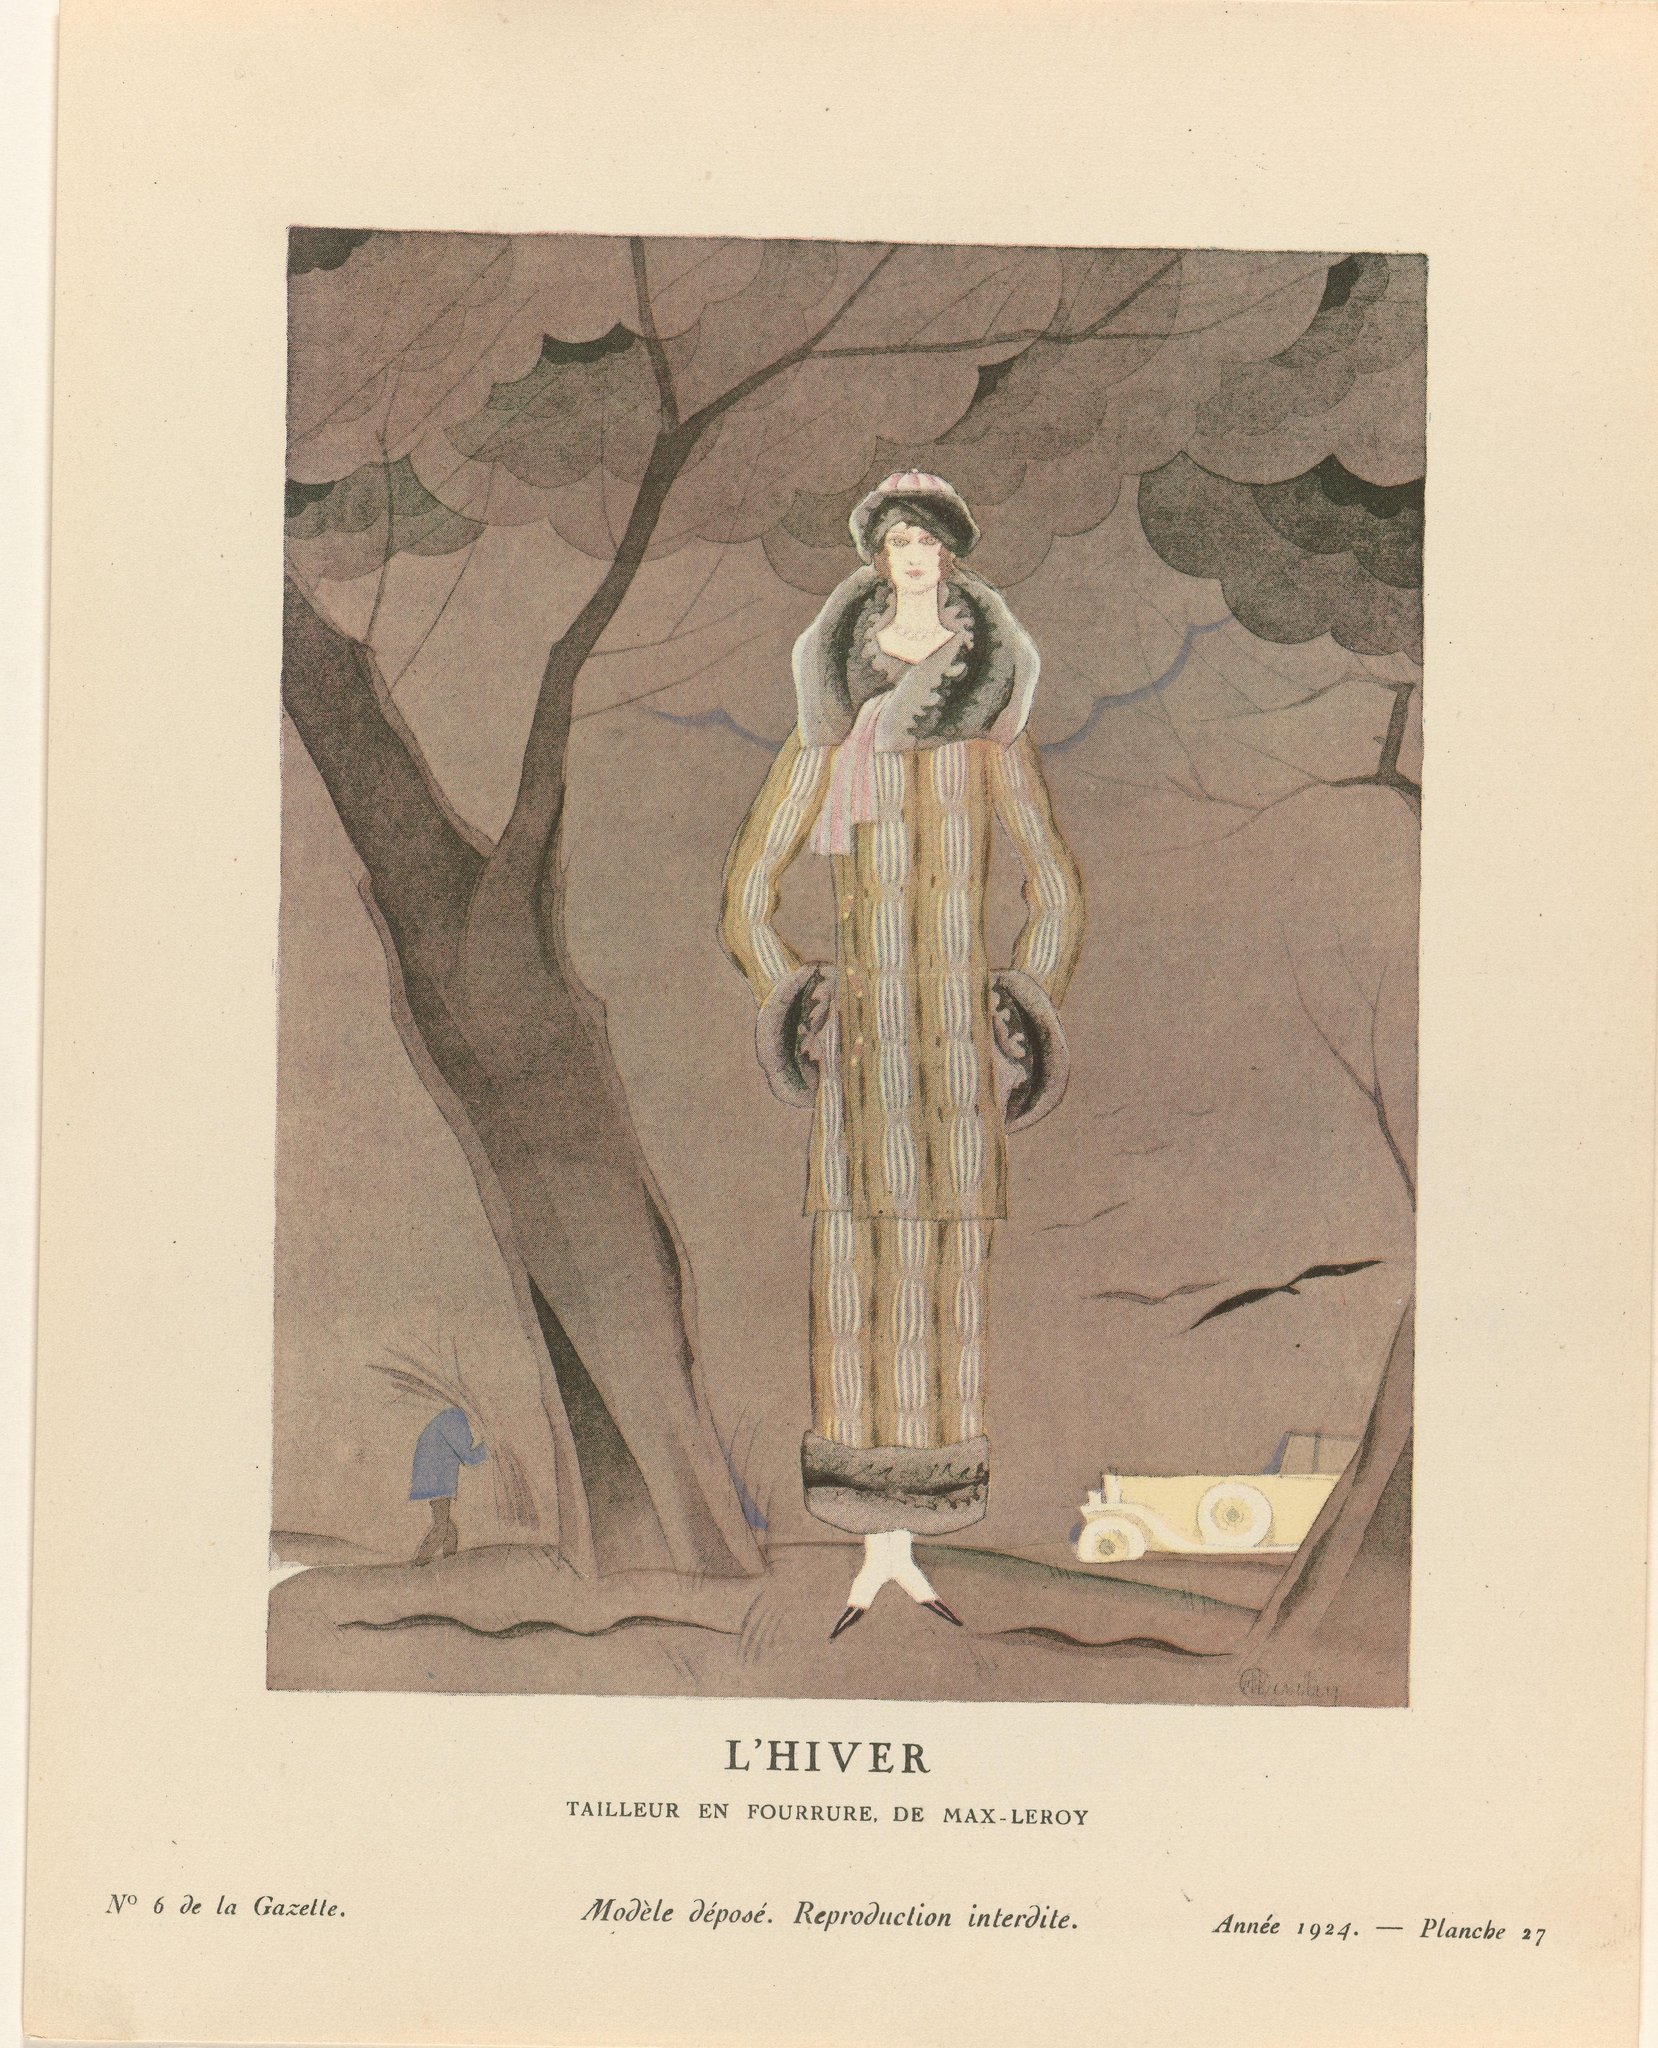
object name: fashion print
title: Gazette du Bon Ton. Art- Modes & Frivolités, 1924 - No. 6 : L'hiver / Tailleur en fourrure, de Max-Leroy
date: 1924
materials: paper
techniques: printing, hand coloring, letterpress printing, photochemical processes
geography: paris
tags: ensembles of pieces of clothing (suit) (+ women's clothes), skirt (+ fur used for clothes), head-gear: cap (+ women's clothes), fashion plates, clothing for the upper part of the body (+ fur used for clothes), automobile, necklace (+ women's clothes), head-gear: cap (+ fur used for clothes)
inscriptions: caption: ‘Modèle déposé. Reproduction interdite.’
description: Staande vrouw in een landschap, gekleed in een mantelpak van bont, van Max-Leroy. Op het hoofd een muts. Op de achtergrond een auto. Planche 27 uit Gazette du Bon Ton 1924, No. 6.